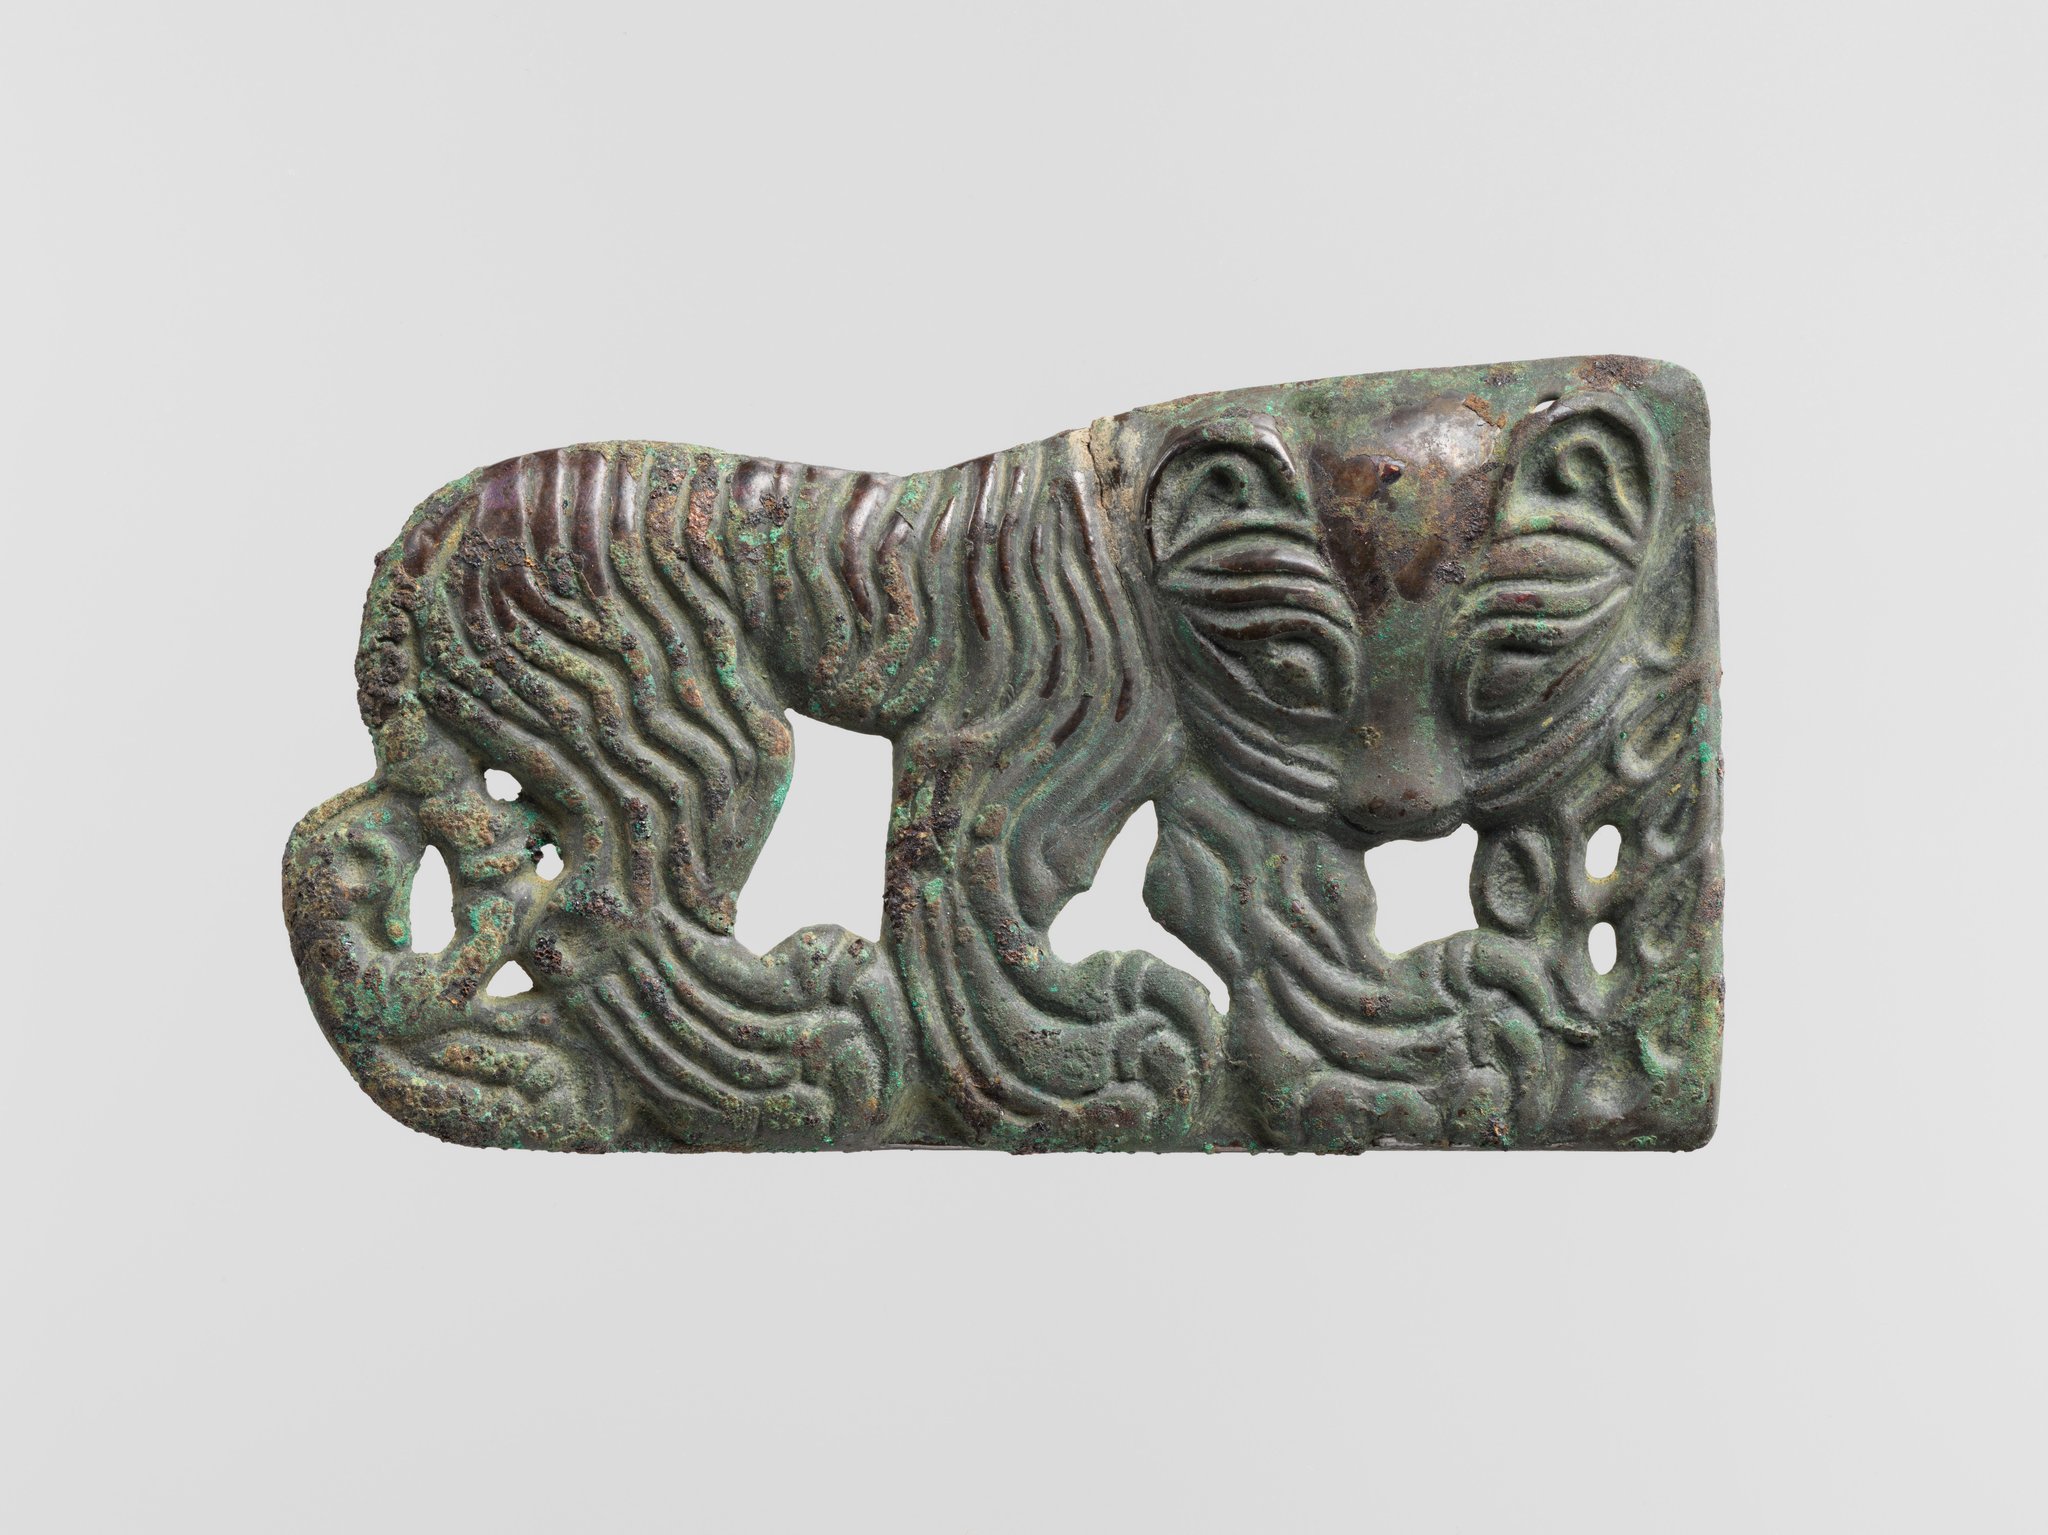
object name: belt buckle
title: Belt buckle with walking tiger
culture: north chinese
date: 300-201 BCE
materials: bronze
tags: tigers